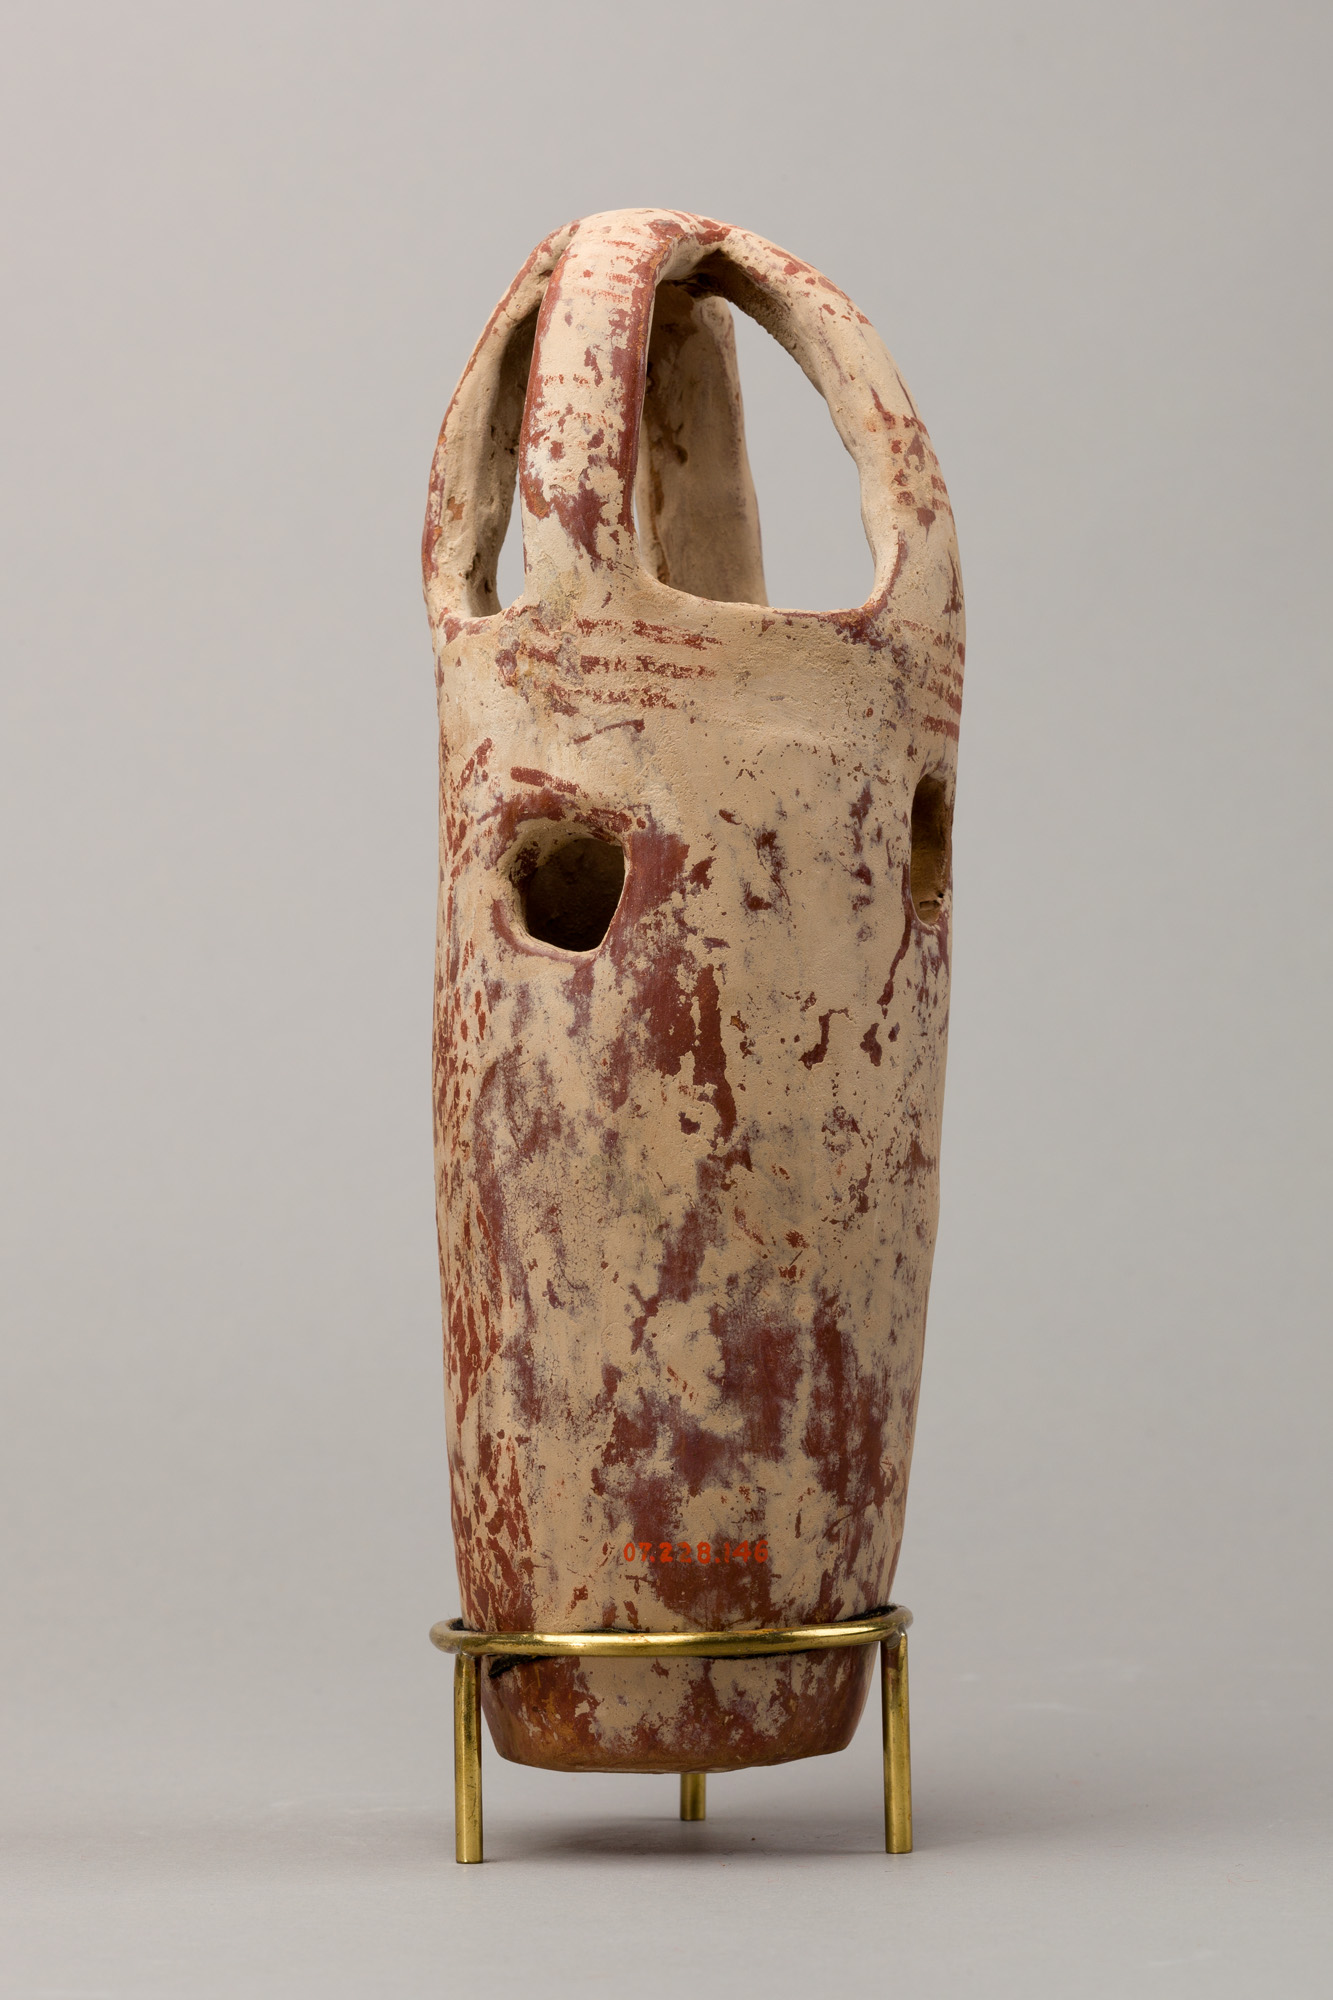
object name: censer, floral design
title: Censer? with floral design in red paint on white background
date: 3850-2960 BCE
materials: paint, pottery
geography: egypt